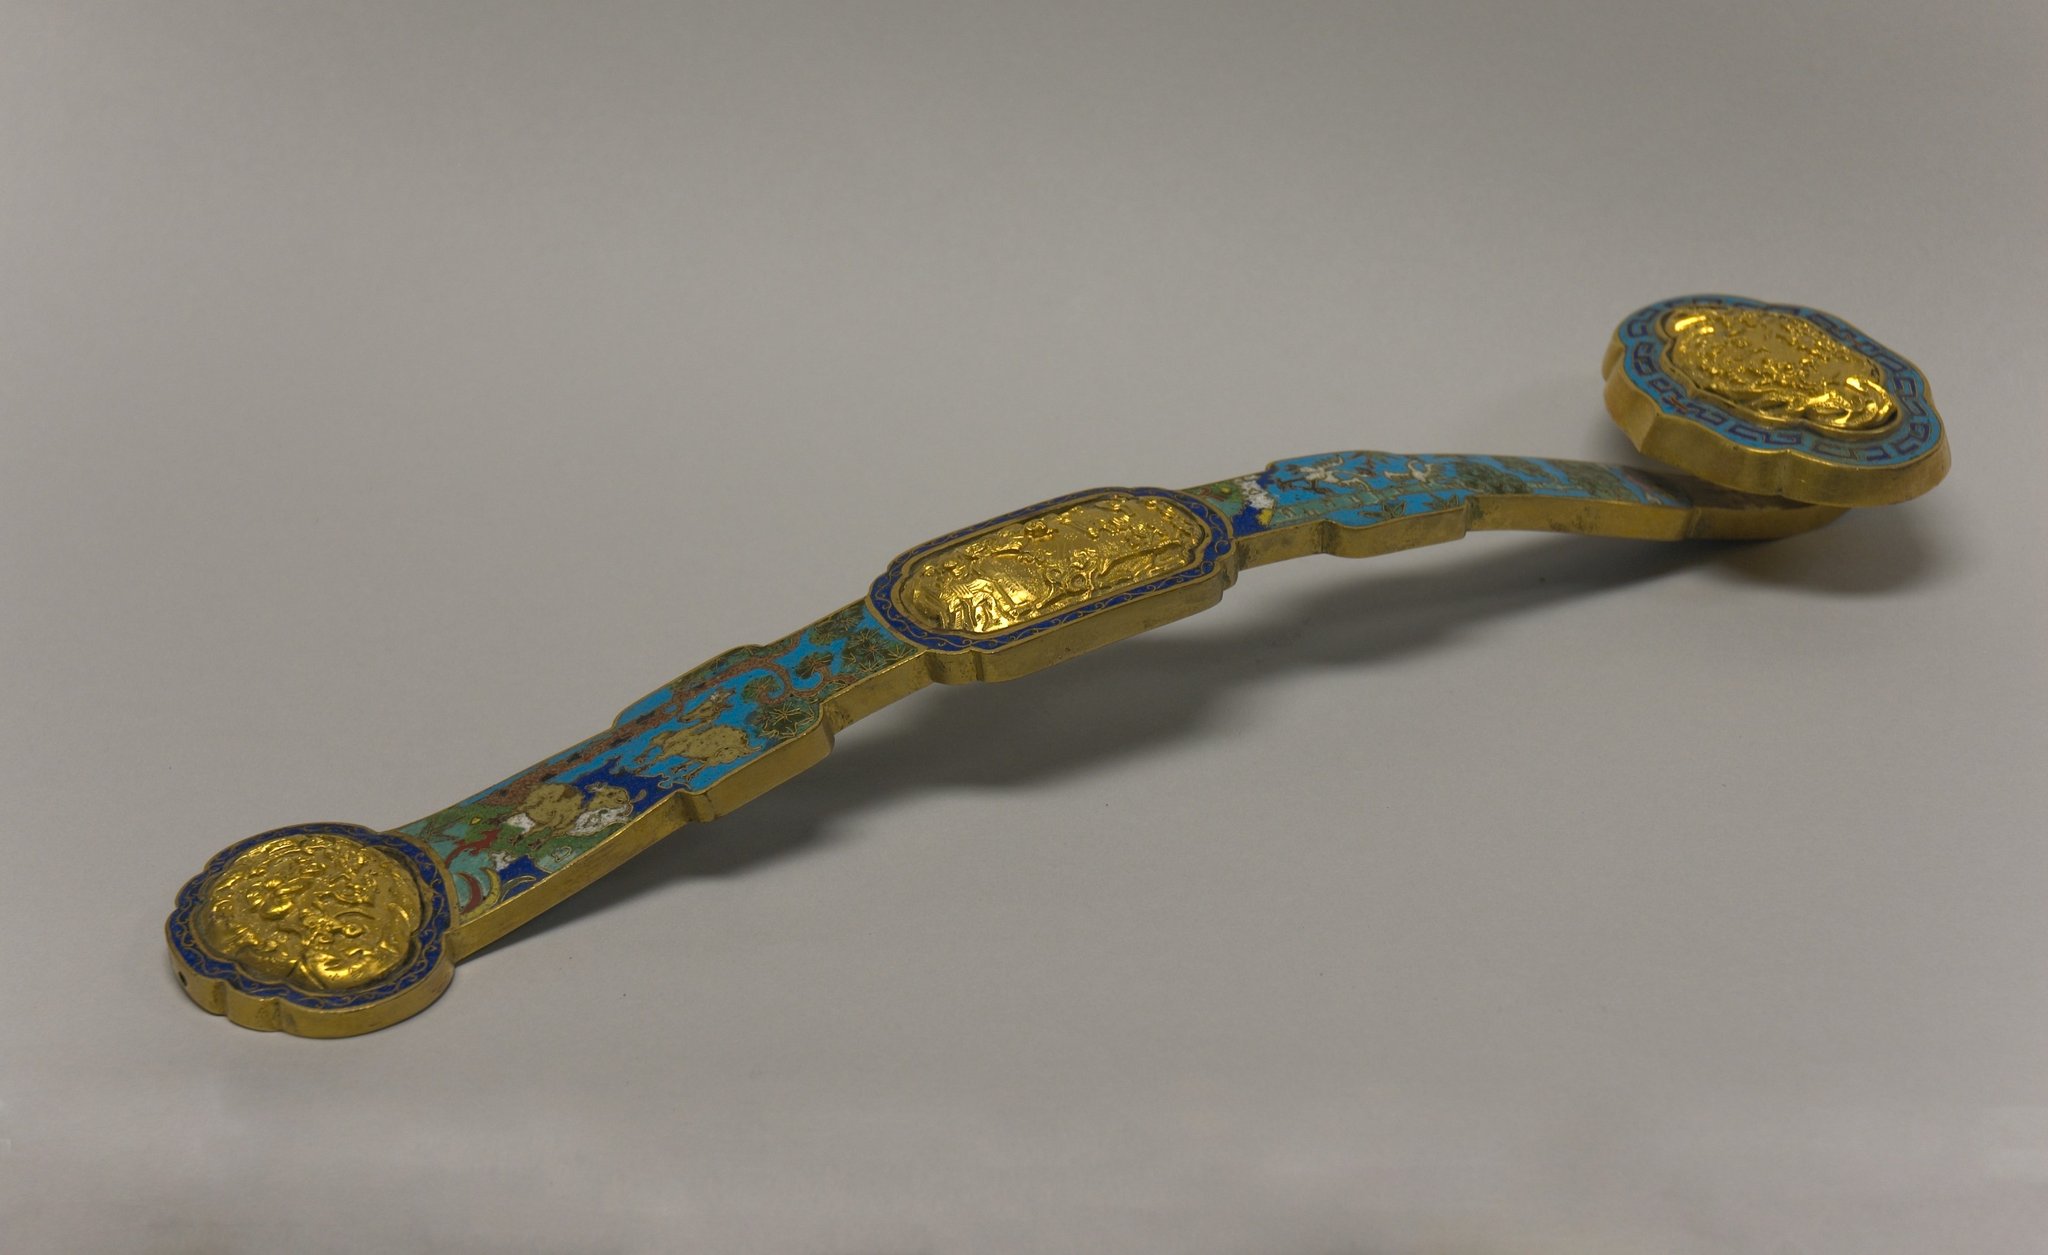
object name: scepter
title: Ruyi Scepter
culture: chinese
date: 1701-1900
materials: enamel, gilt bronze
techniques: enamel